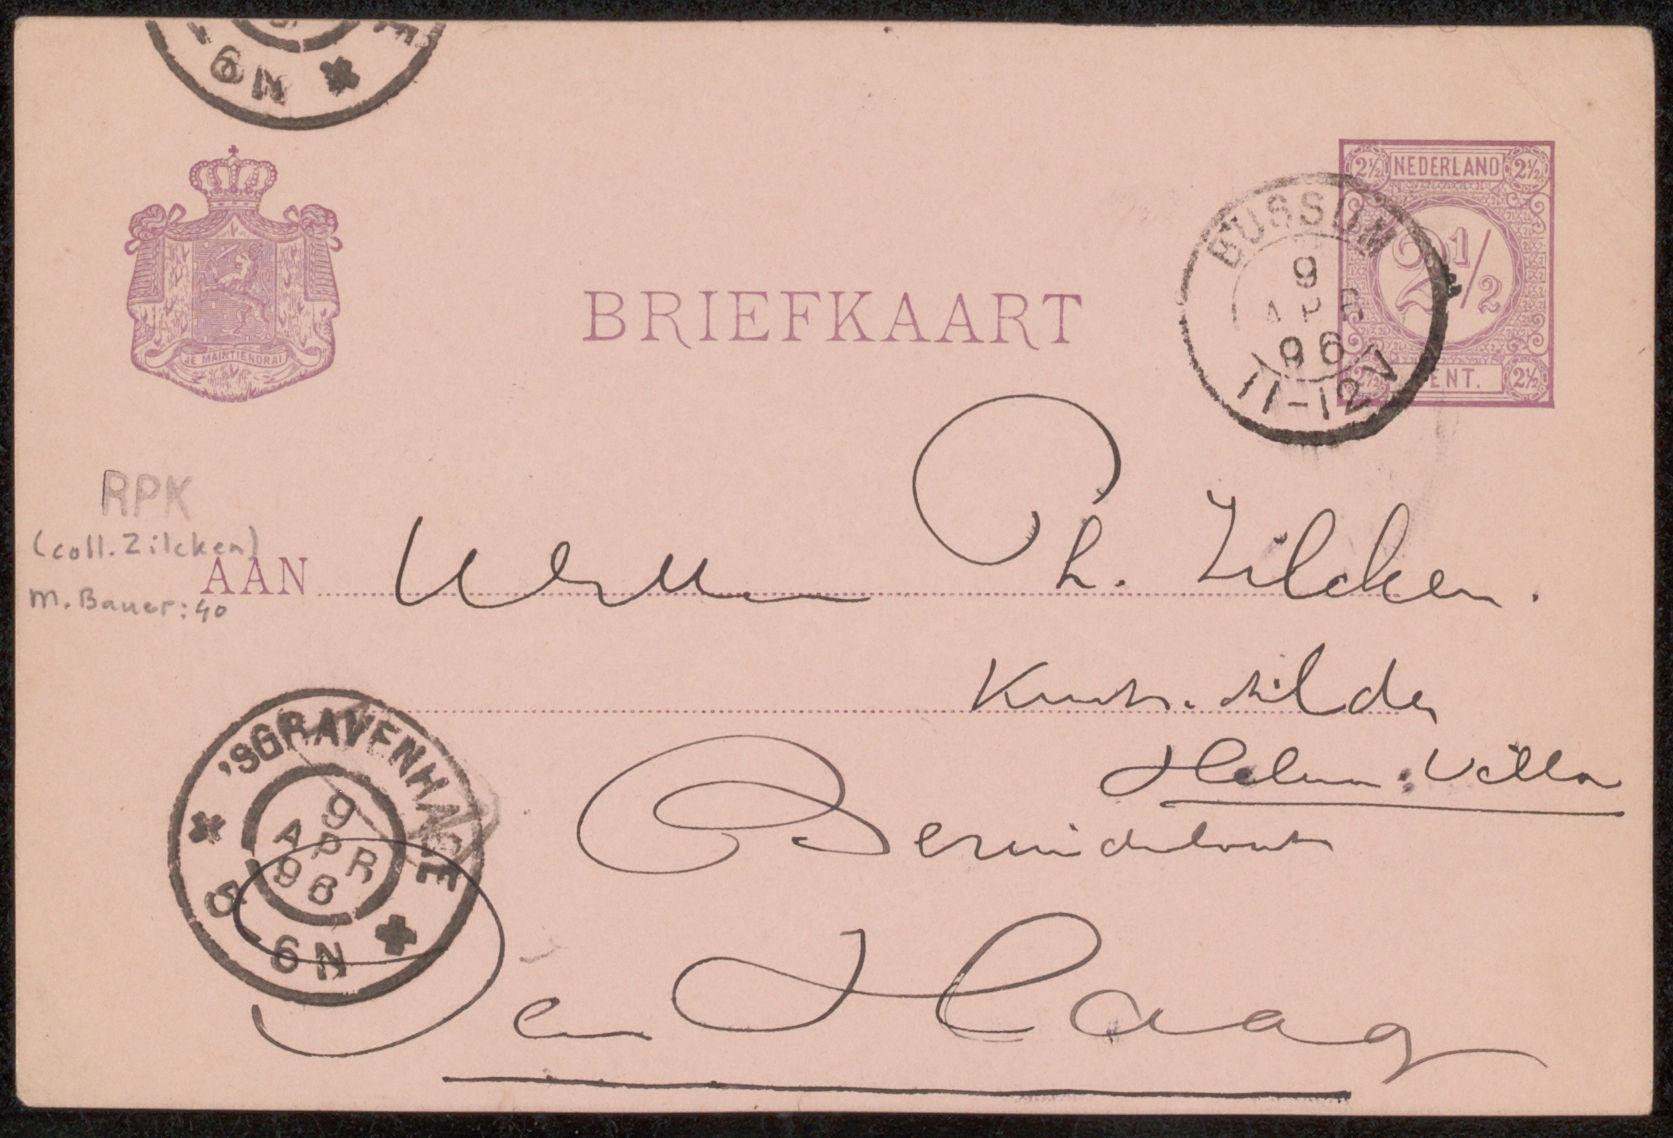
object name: postcard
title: Briefkaart aan Philip Zilcken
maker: marius bauer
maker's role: draughtsman, print maker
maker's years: 1867-1932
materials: cardboard, ink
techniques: pen, writing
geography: bussum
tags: painter, philip zilcken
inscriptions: collector's mark: ‘RPK’